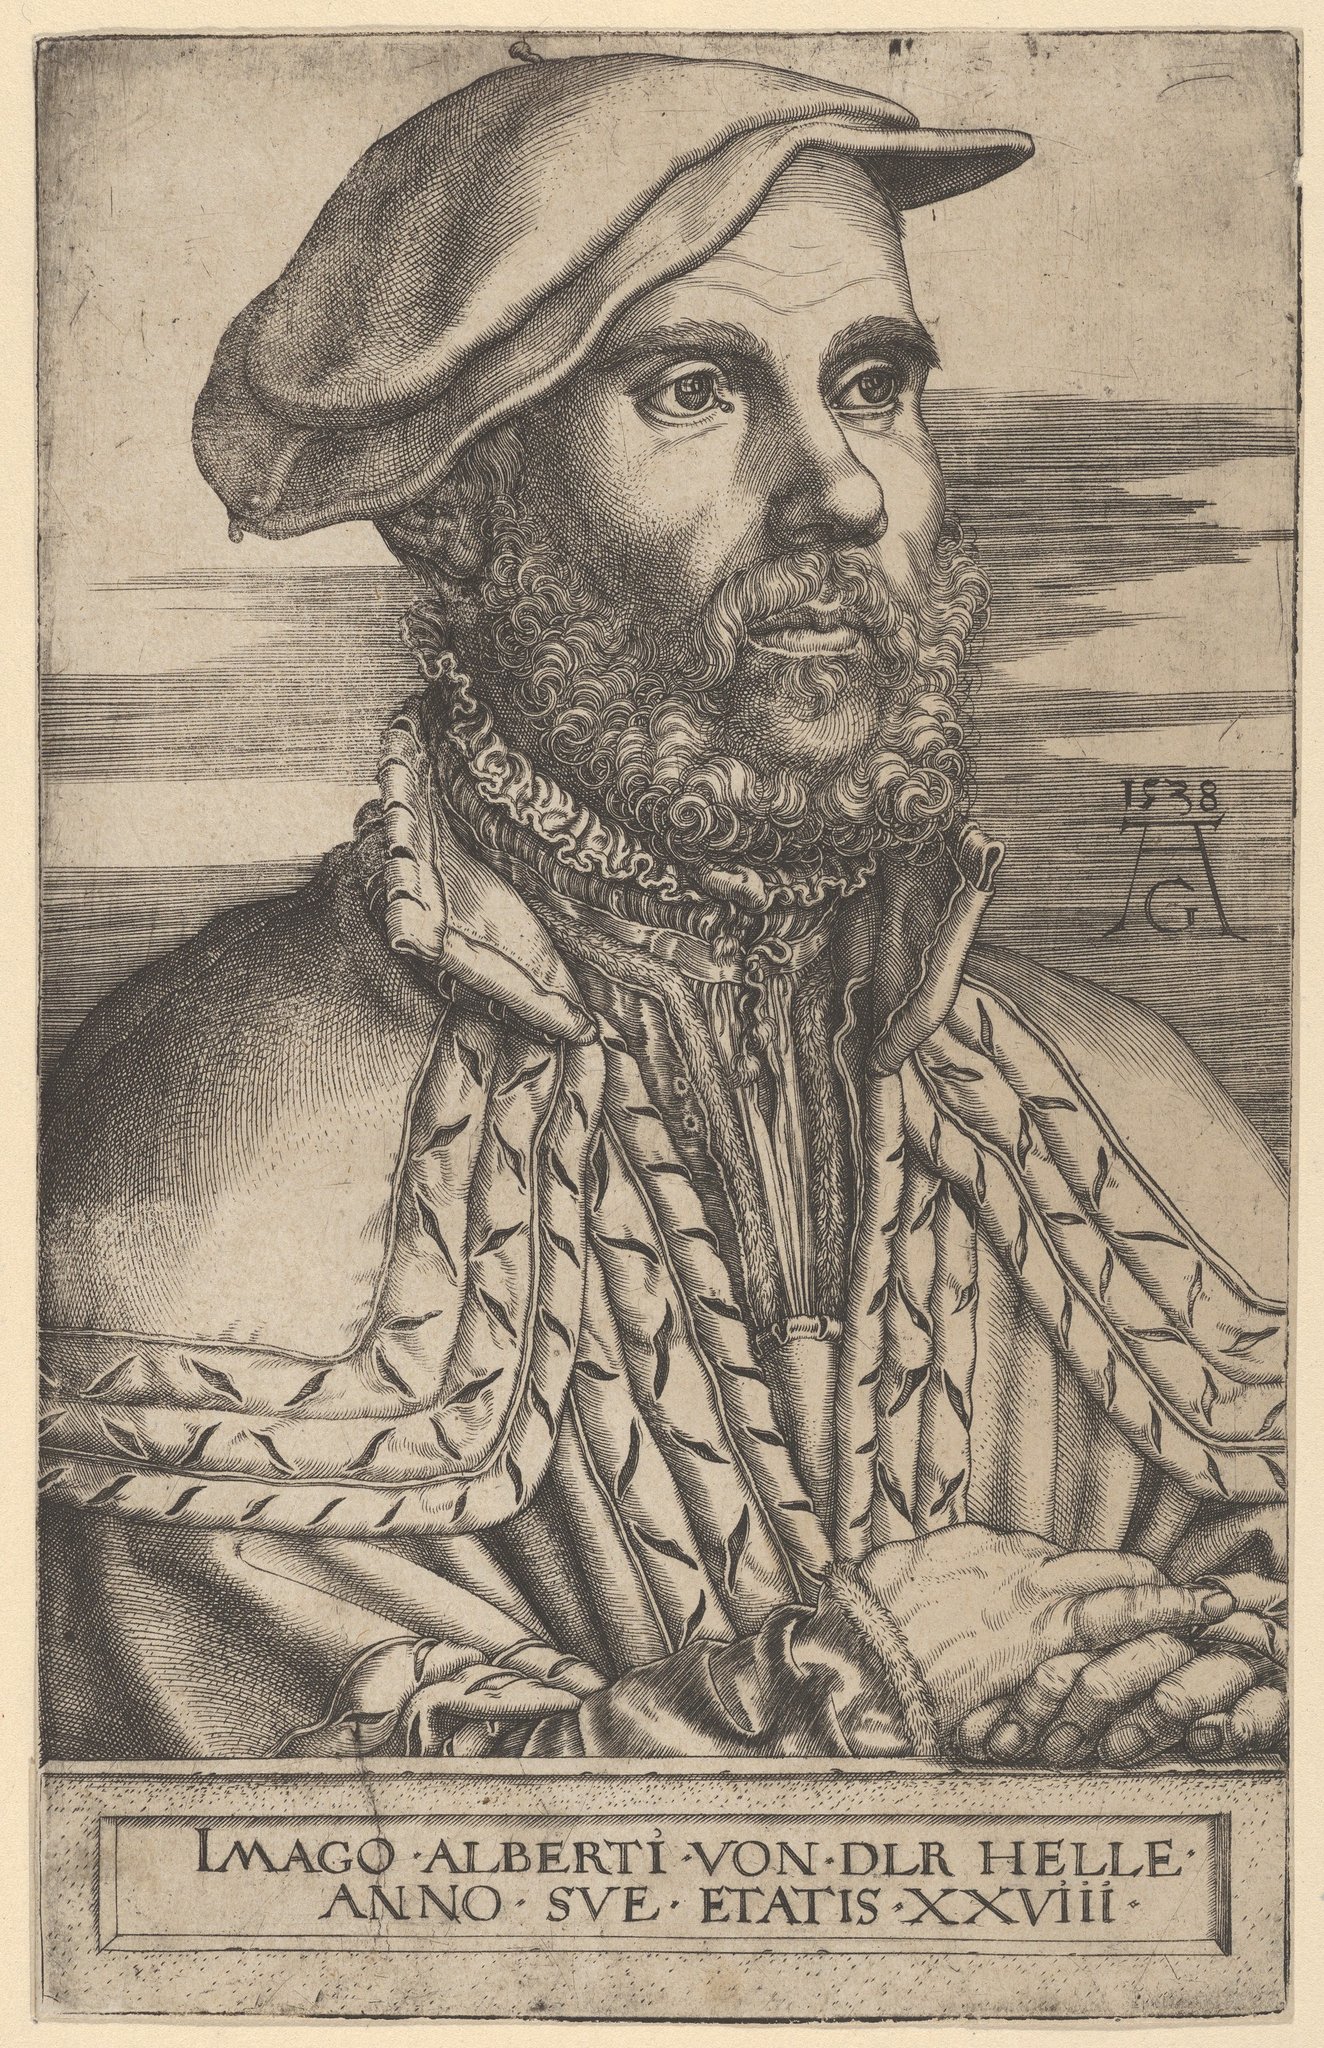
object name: print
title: Albert van der Helle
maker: heinrich aldegrever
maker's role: artist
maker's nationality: german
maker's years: 1502-1561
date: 1538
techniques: engraving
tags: men,portraits